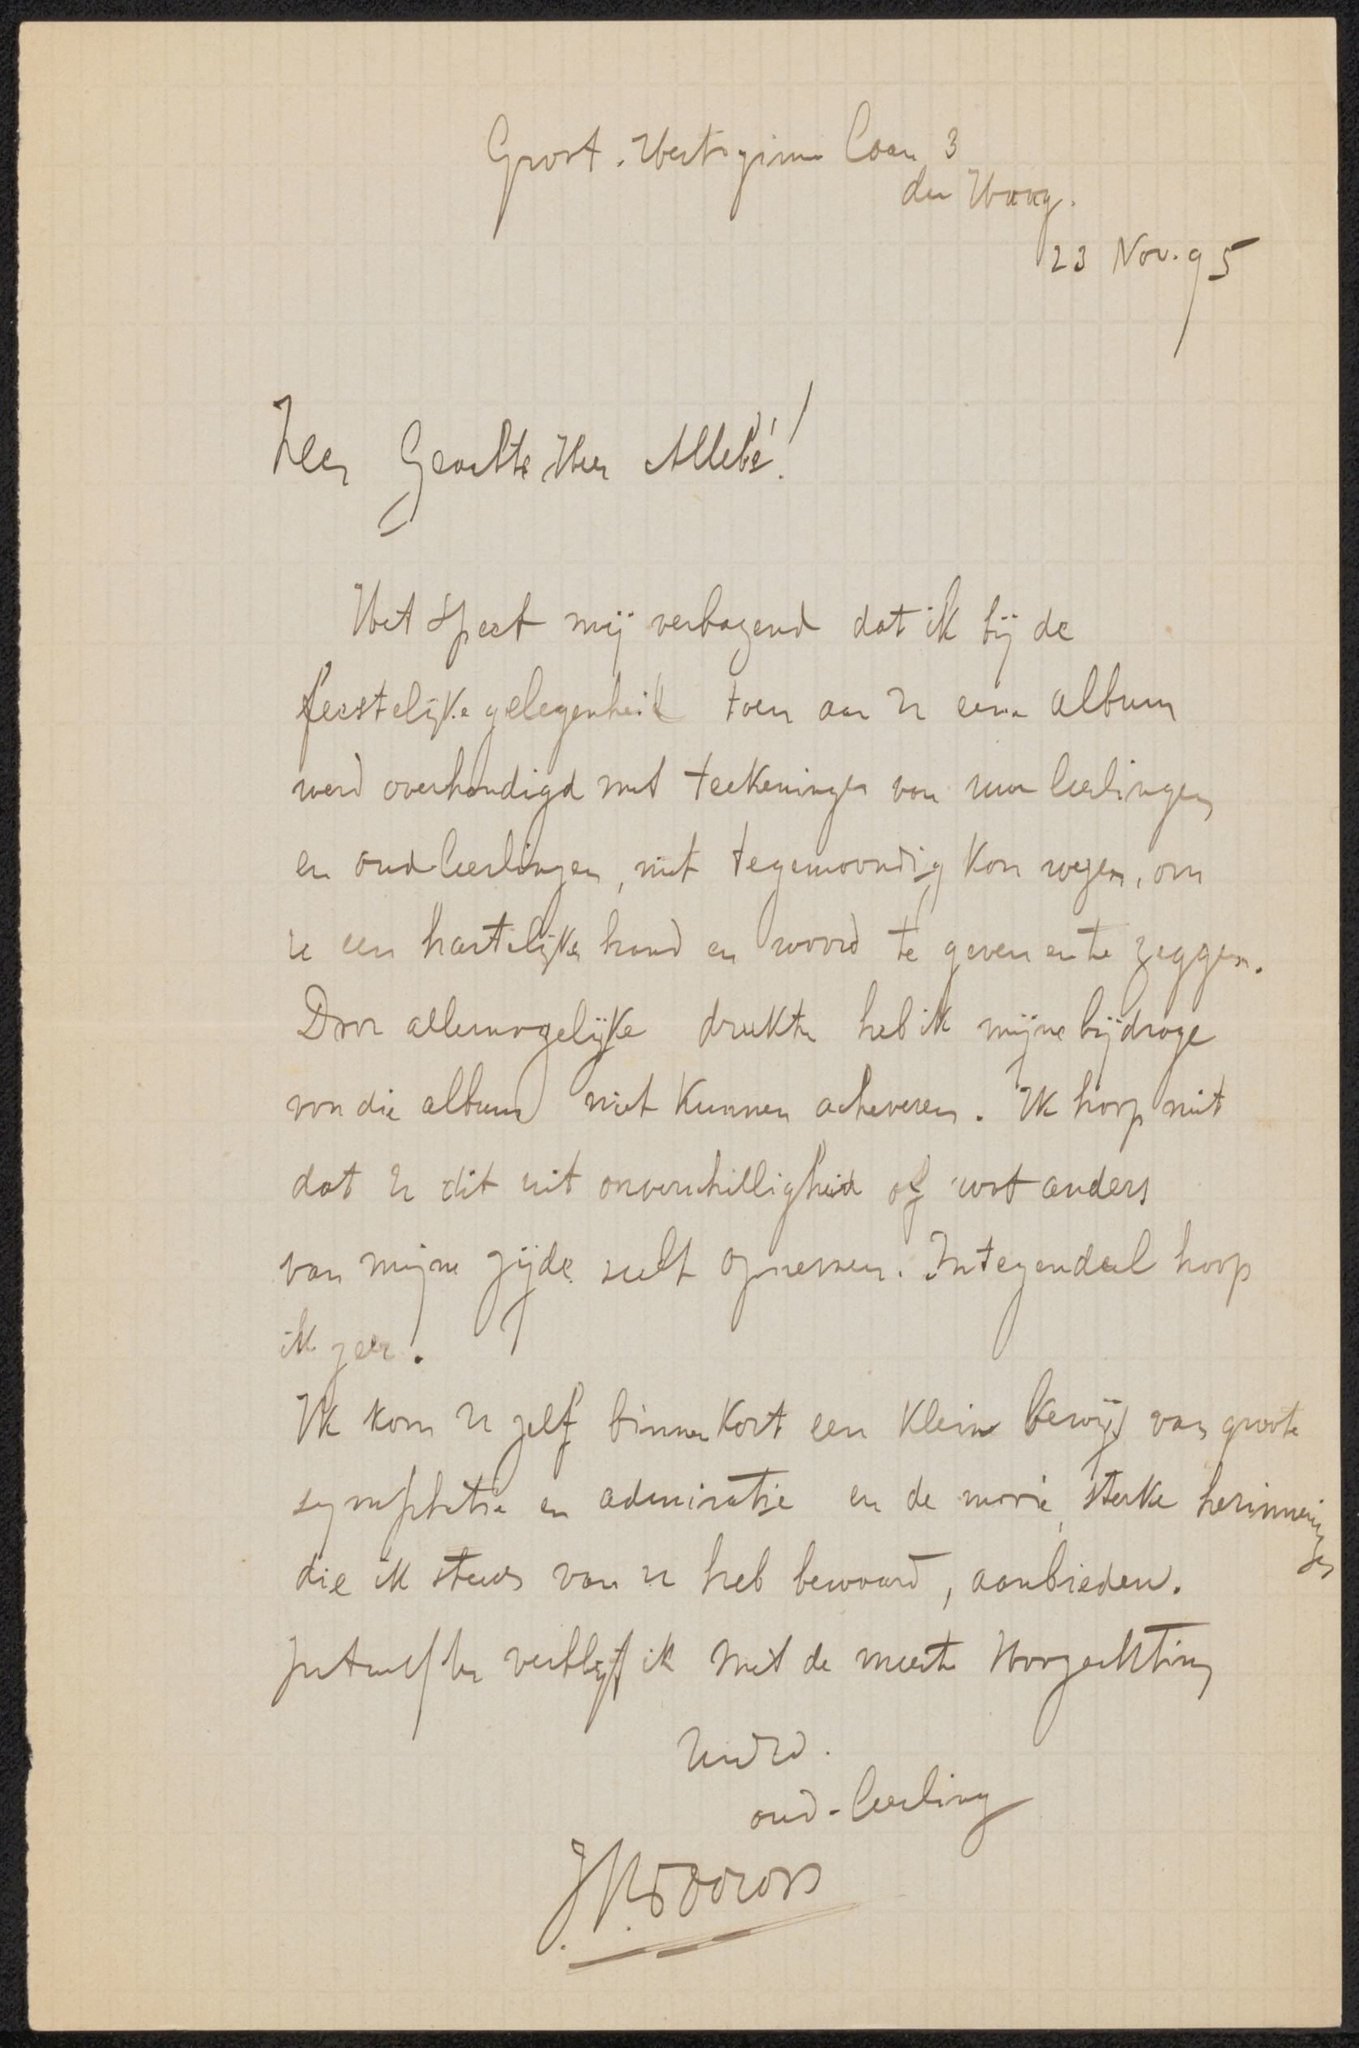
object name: letter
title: Brief aan August Allebé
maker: jan toorop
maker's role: draughtsman, painter, print maker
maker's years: 1858-1928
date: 1895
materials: ink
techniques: pen, writing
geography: the hague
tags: amsterdam, print maker, draughtsman, august allebé, drawing, education, tuition of the artist (in general)